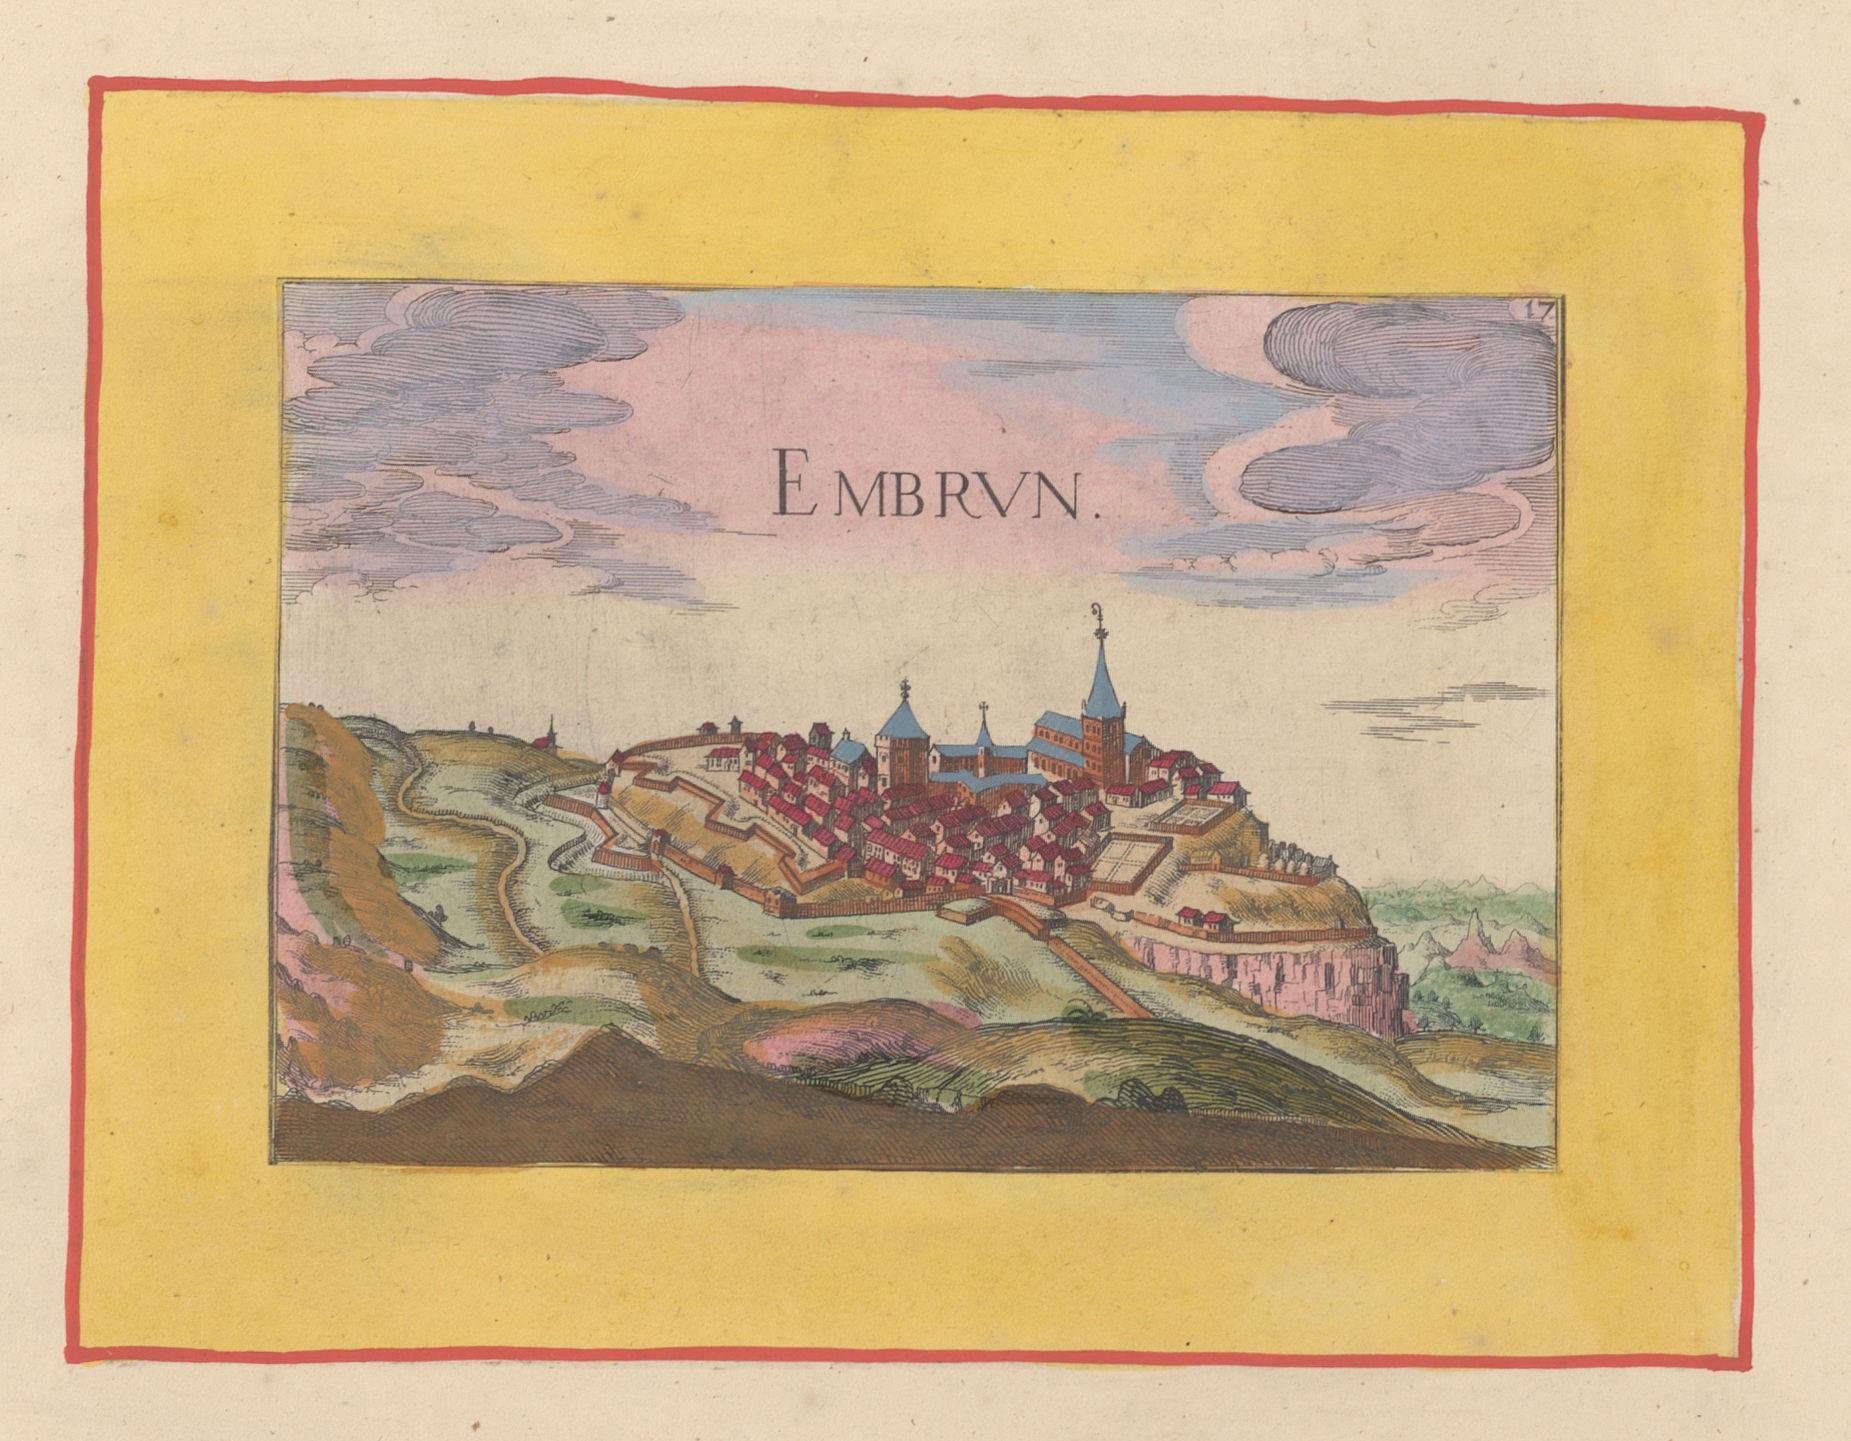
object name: album leaf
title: Gezicht op Embrun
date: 1638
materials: paper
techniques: engraving, etching, hand coloring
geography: the hague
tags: maps of cities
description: Prent uit: Tassin, Christophe. Les plans et profils de toutes les principales villes et lieux considérables de France (...). Parijs: Michel van Lochom, 1638, kaart 16 uit het deel 'Dauphiné'.